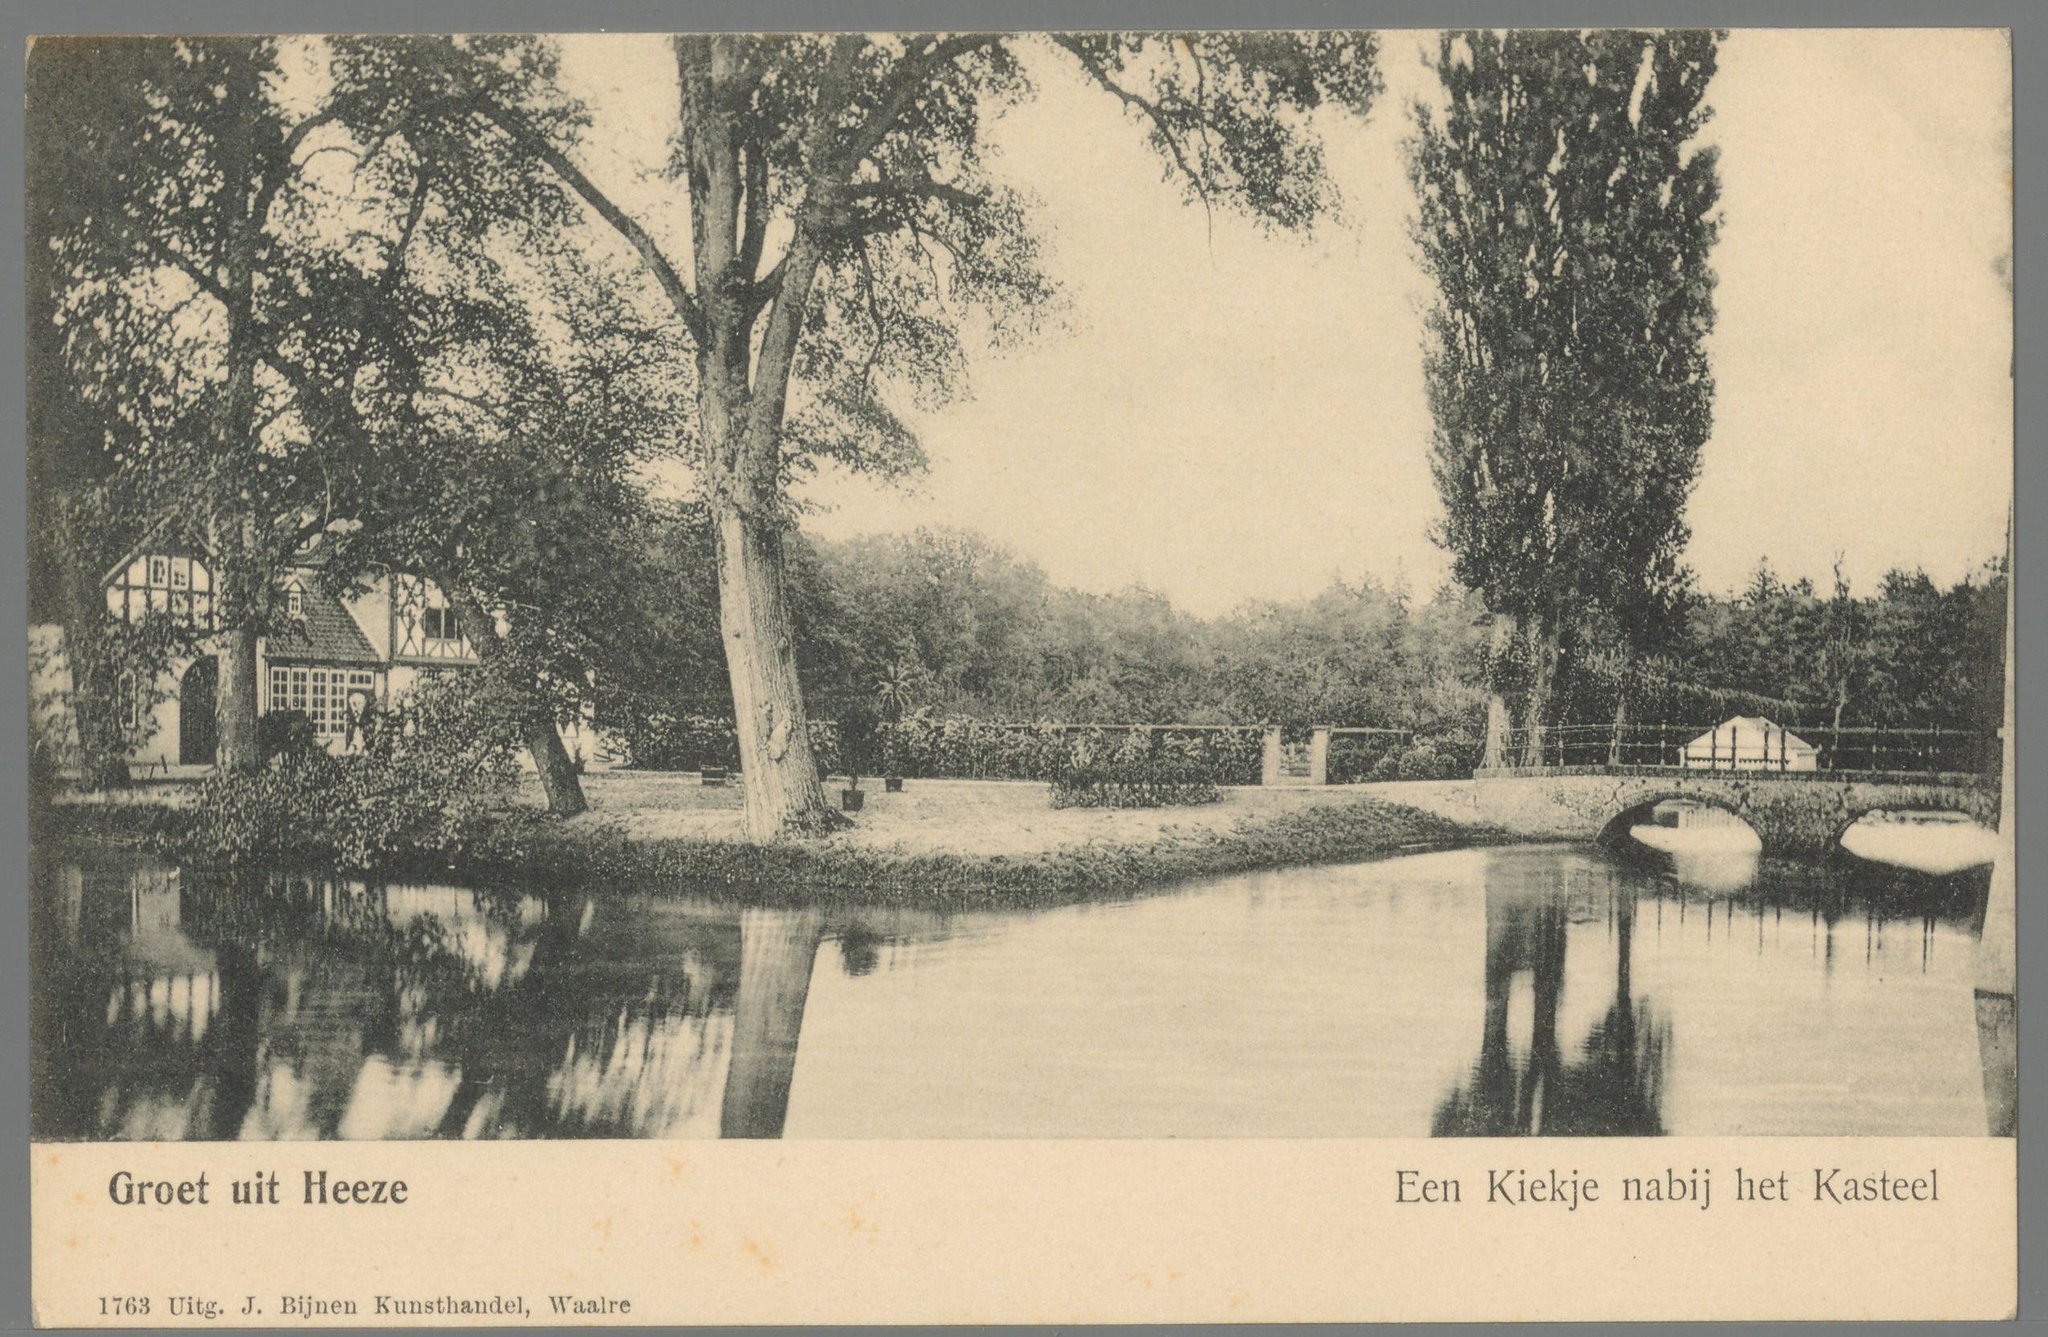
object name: ansichtkaart, prentbriefkaart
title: Groet uit Heeze. Een kiekje nabij het Kasteel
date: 1897-1905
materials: cardboard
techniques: photograph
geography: heeze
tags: pond, bridge